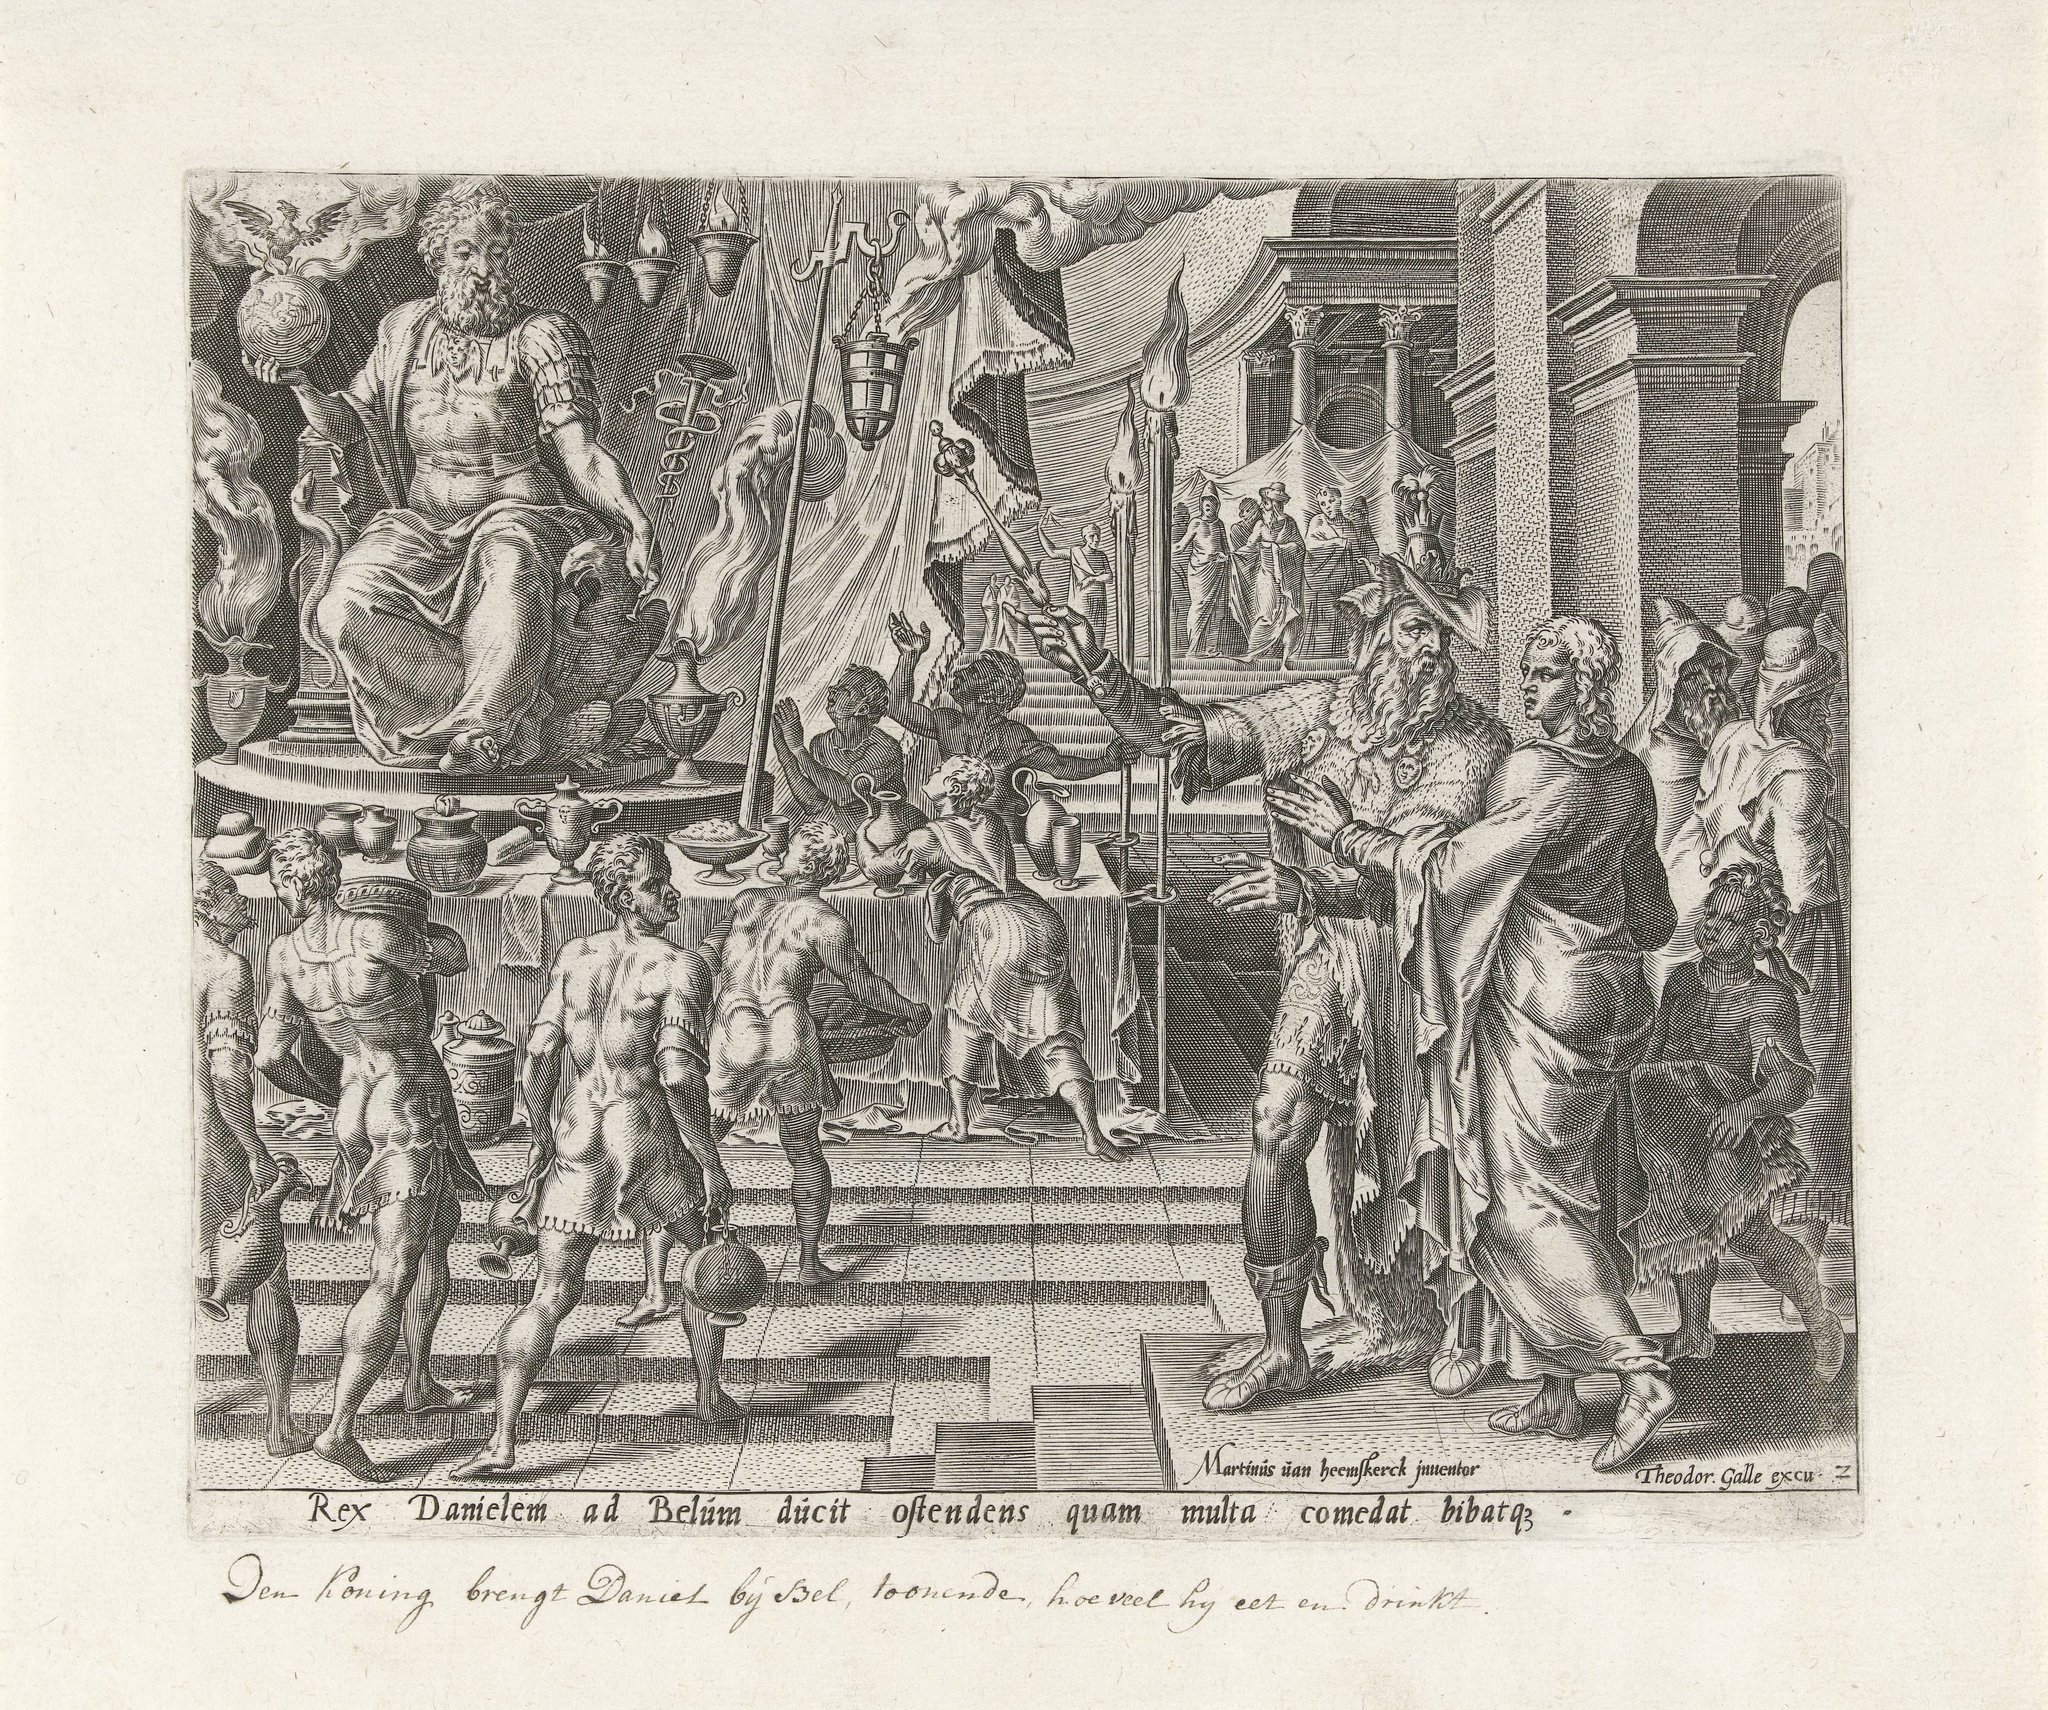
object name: print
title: Geschiedenis van Daniël, Bel en de draak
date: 1601-1633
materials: paper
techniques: engraving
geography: haarlem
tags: king cyrus sets food before the image of bel; daniel and his servants strew ashes on the floor of the temple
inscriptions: collector's mark: Lugt 2228, inscription: ‘Den koning brengt Daniel bij Bel...’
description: Koning Cyrus toont Daniël de tempel van de god Bel. In het midden van de tempel staat een groot beeld van de zittende godheid. Eromheen staan vazen met reukwerk. Dienaren zijn bezig om op een tafel voor het beeld eten en drinken uit te stallen.